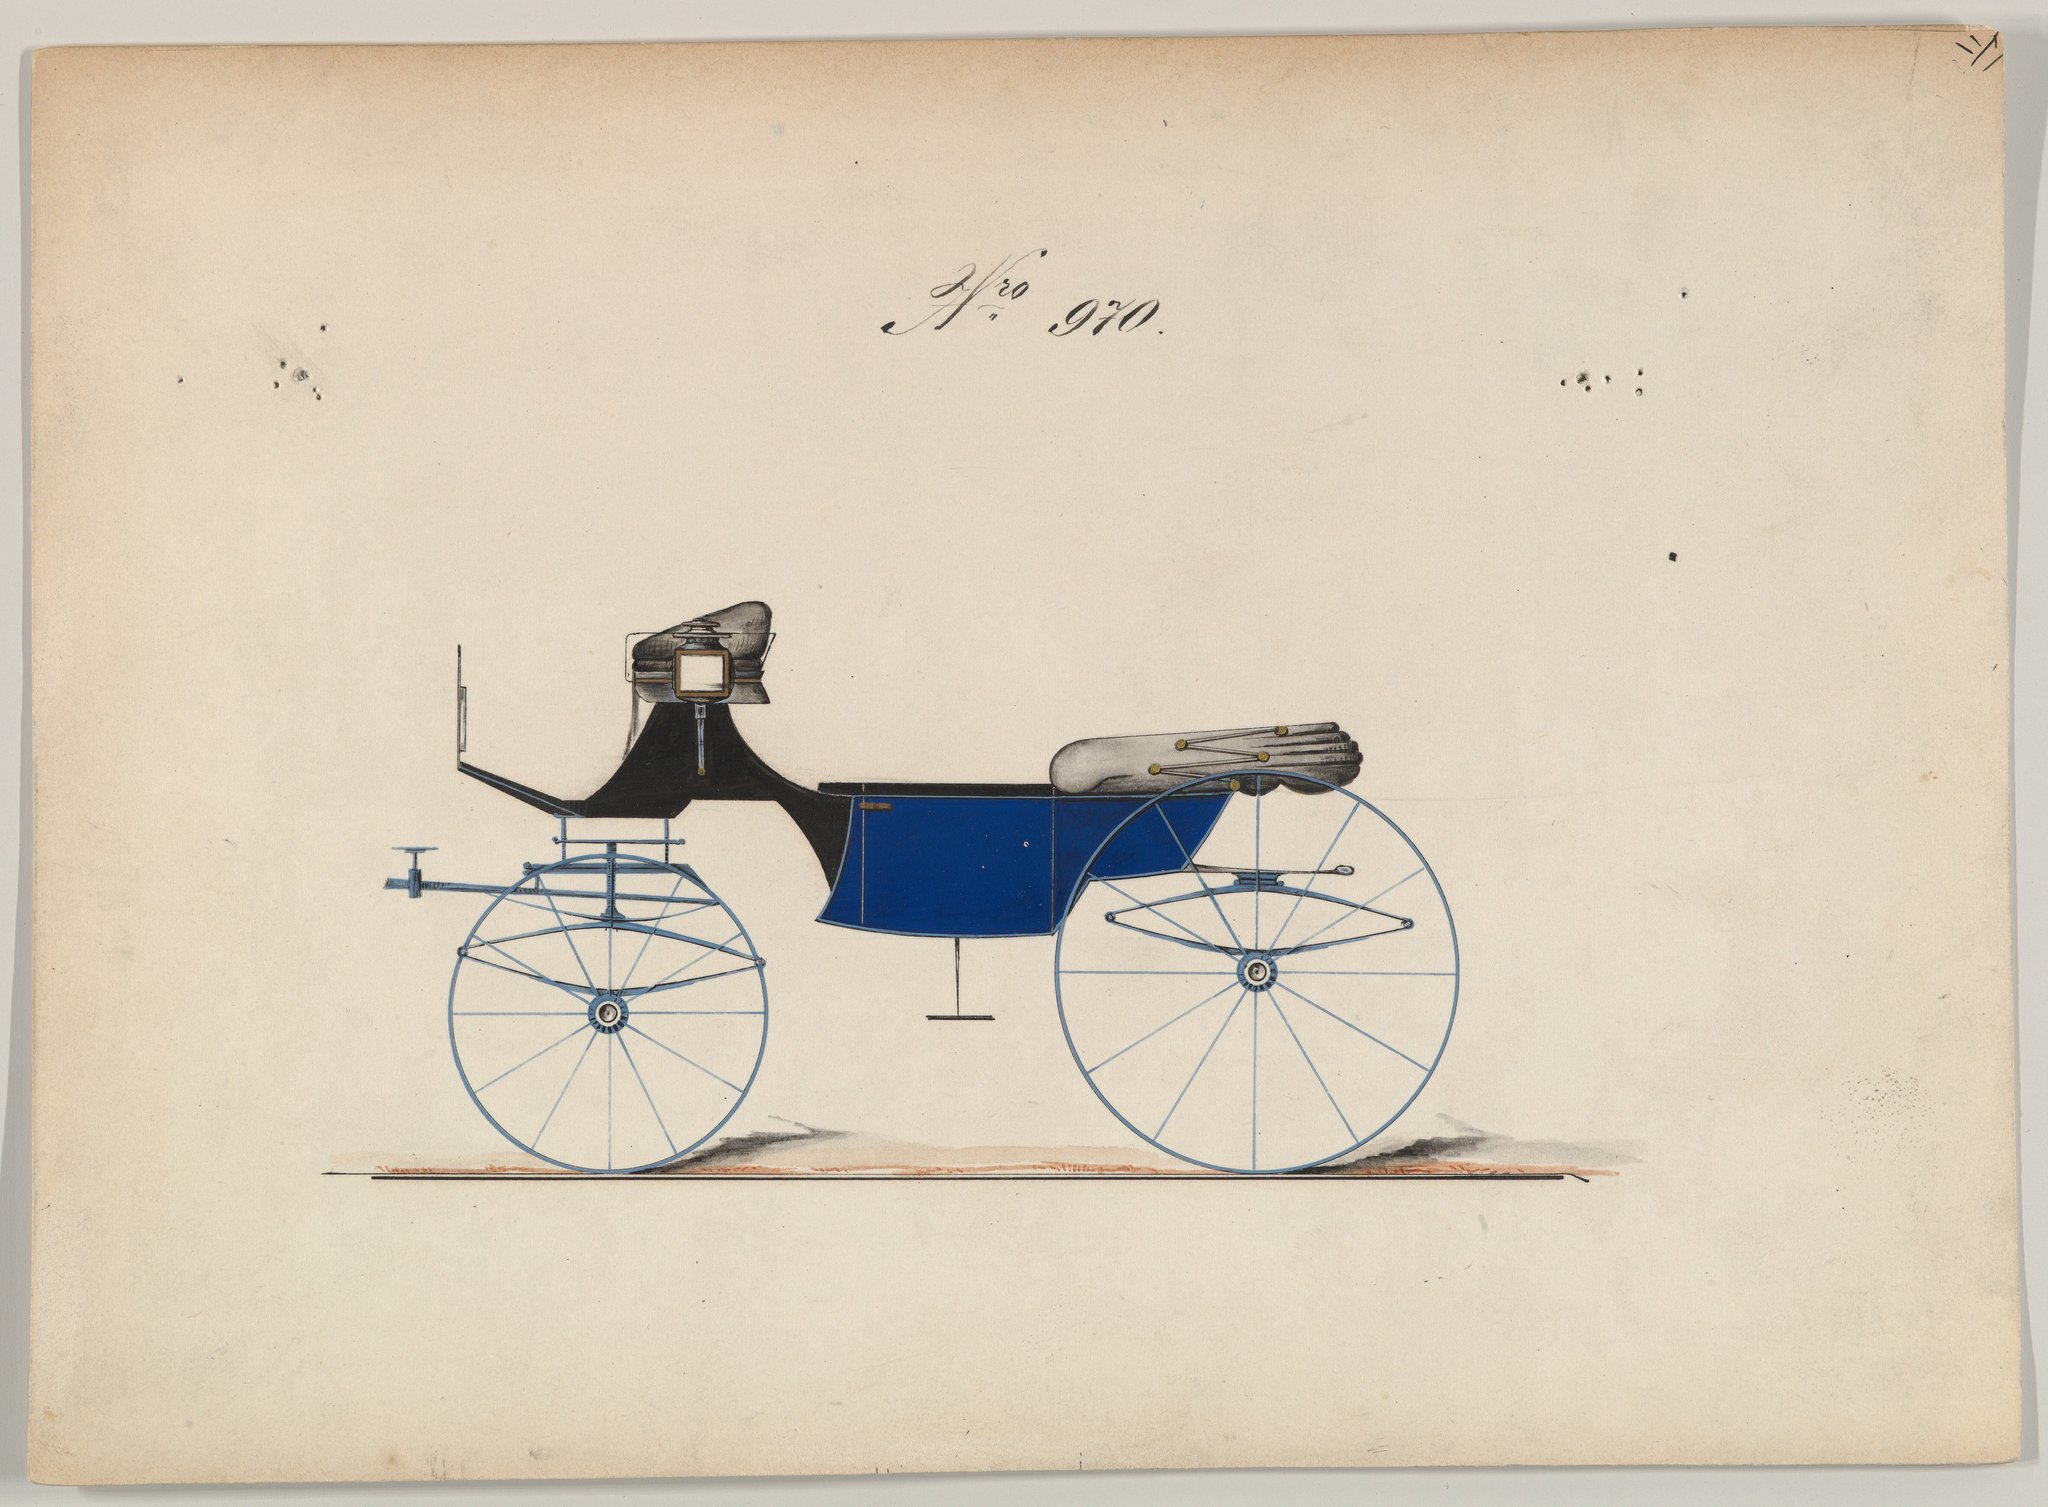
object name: drawing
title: Landaulet #970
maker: brewster & co.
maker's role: manufacturer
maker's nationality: american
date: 1850-1870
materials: gouache, gum arabic, ink, watercolor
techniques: pen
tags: carriages